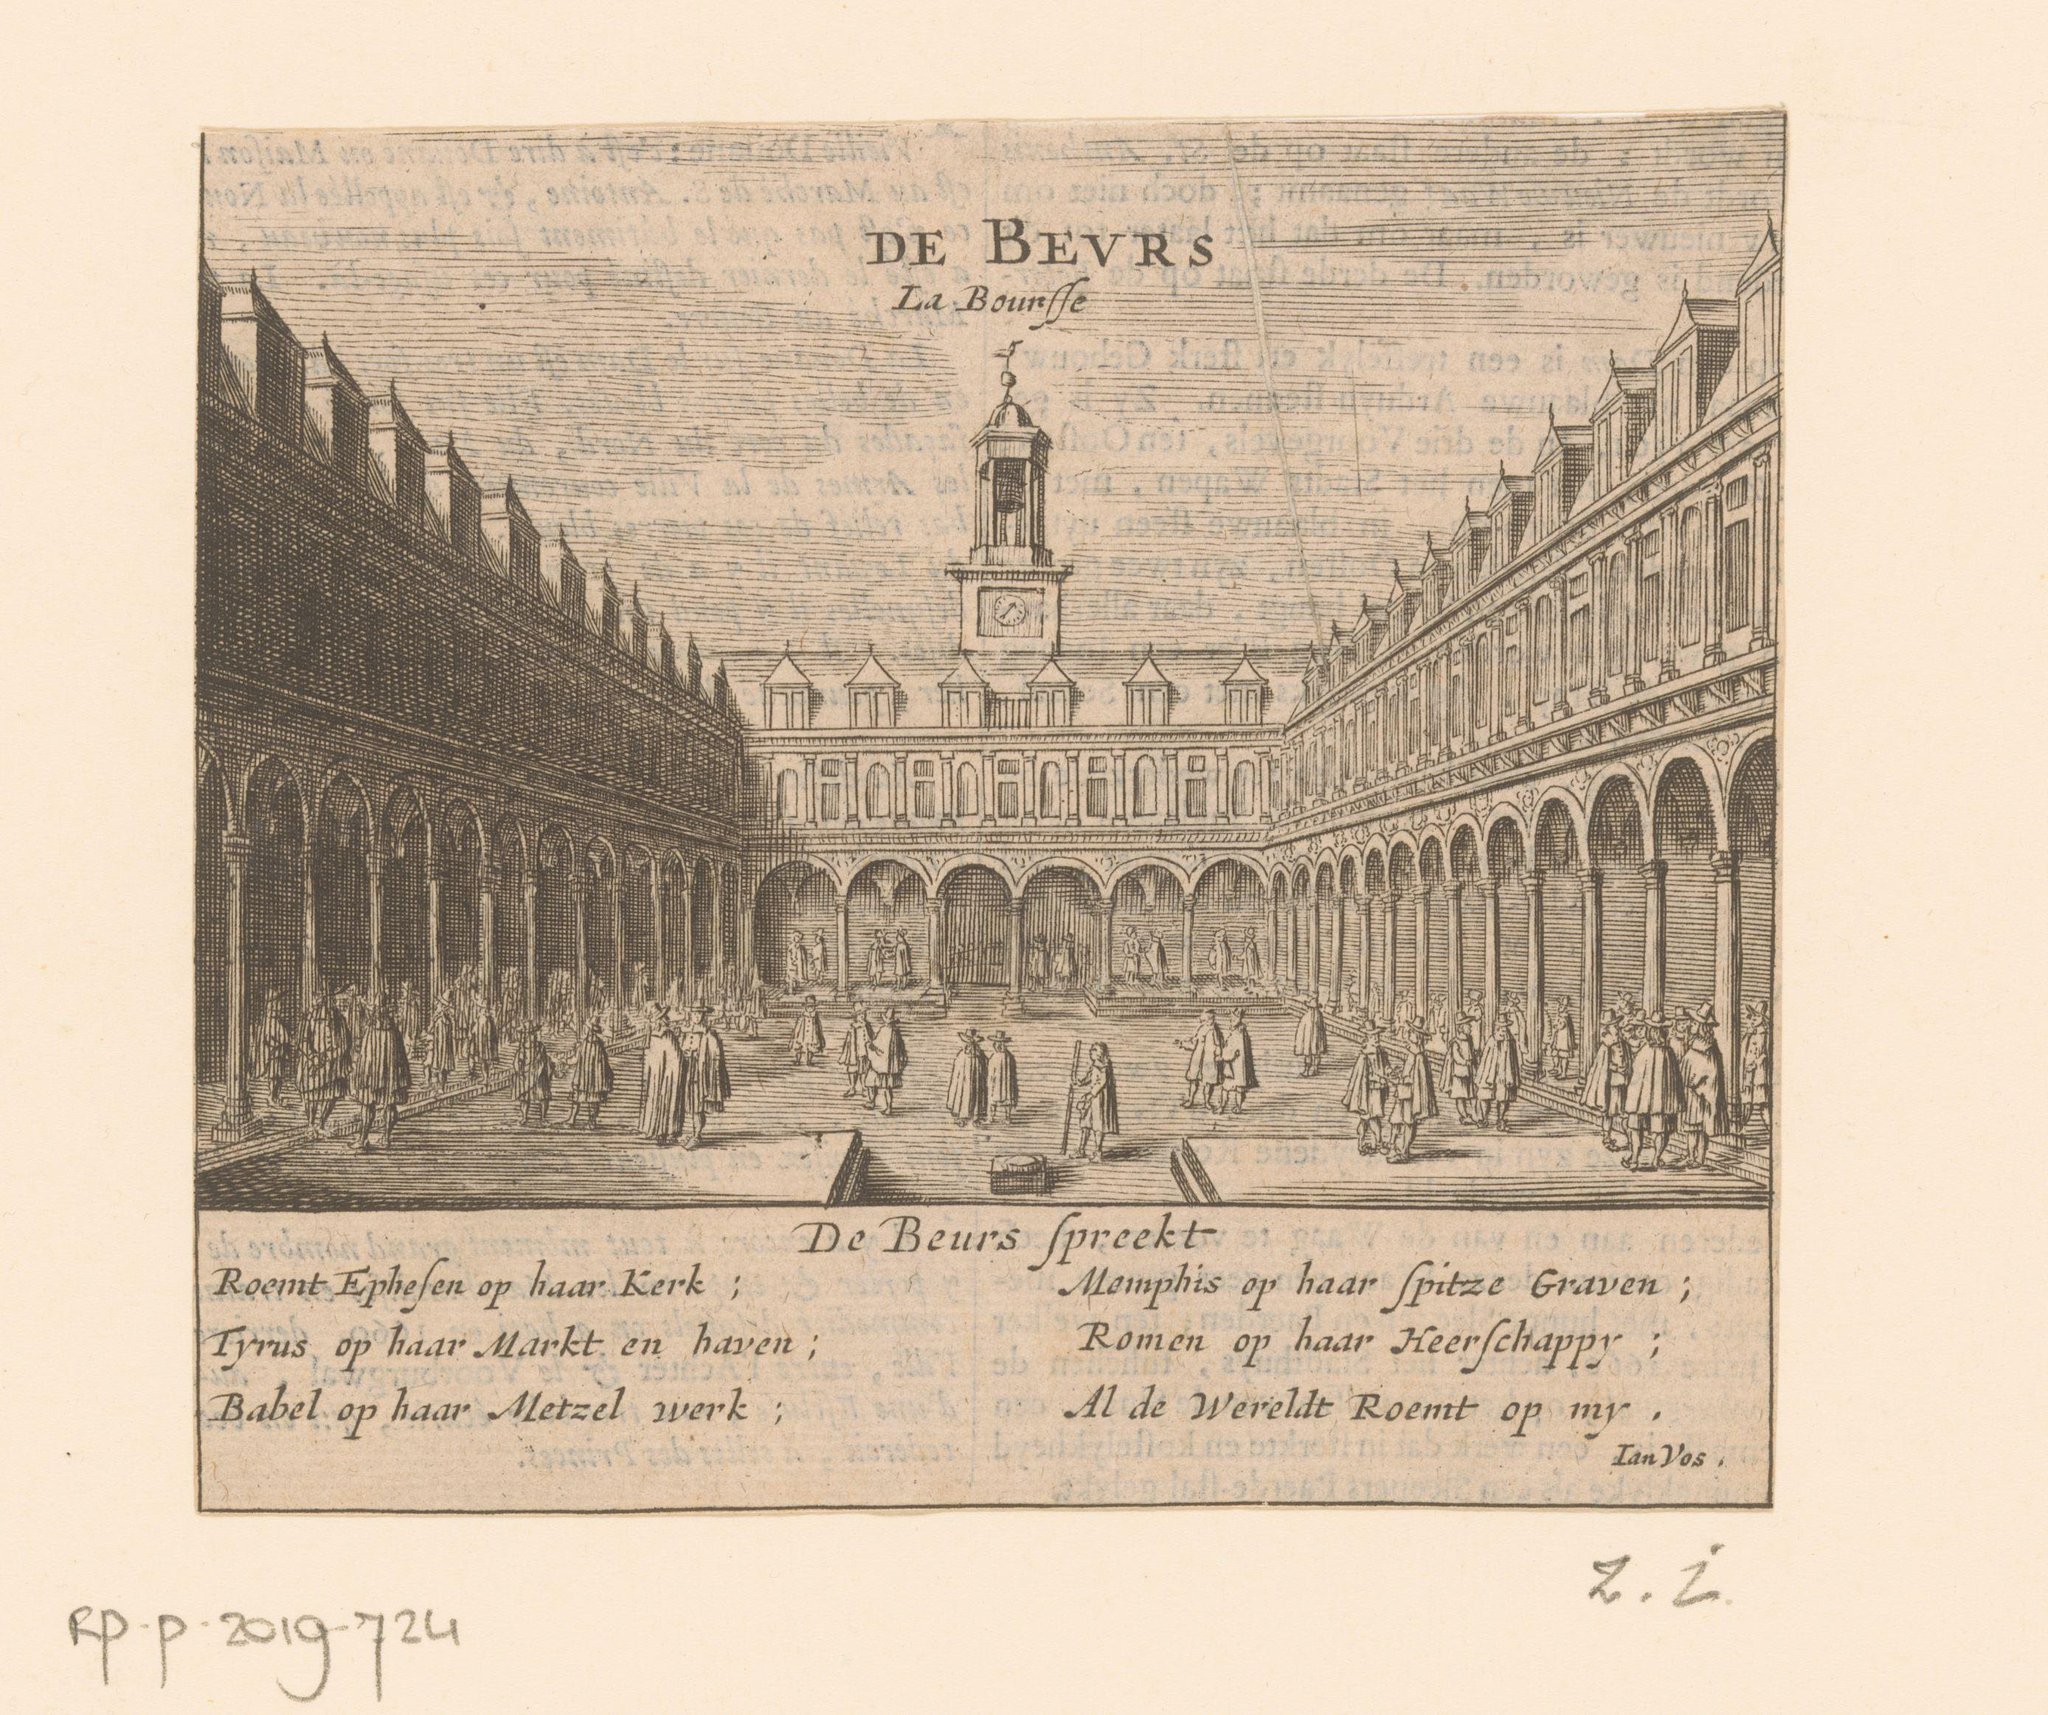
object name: book illustration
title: Gezicht op de binnenplaats van de Beurs van Hendrick de Keyser in Amsterdam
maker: Anonymous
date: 1610-1750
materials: paper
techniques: engraving, etching, letterpress printing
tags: tower, clock tower ~ monumental adornment, stock exchange, stock-market